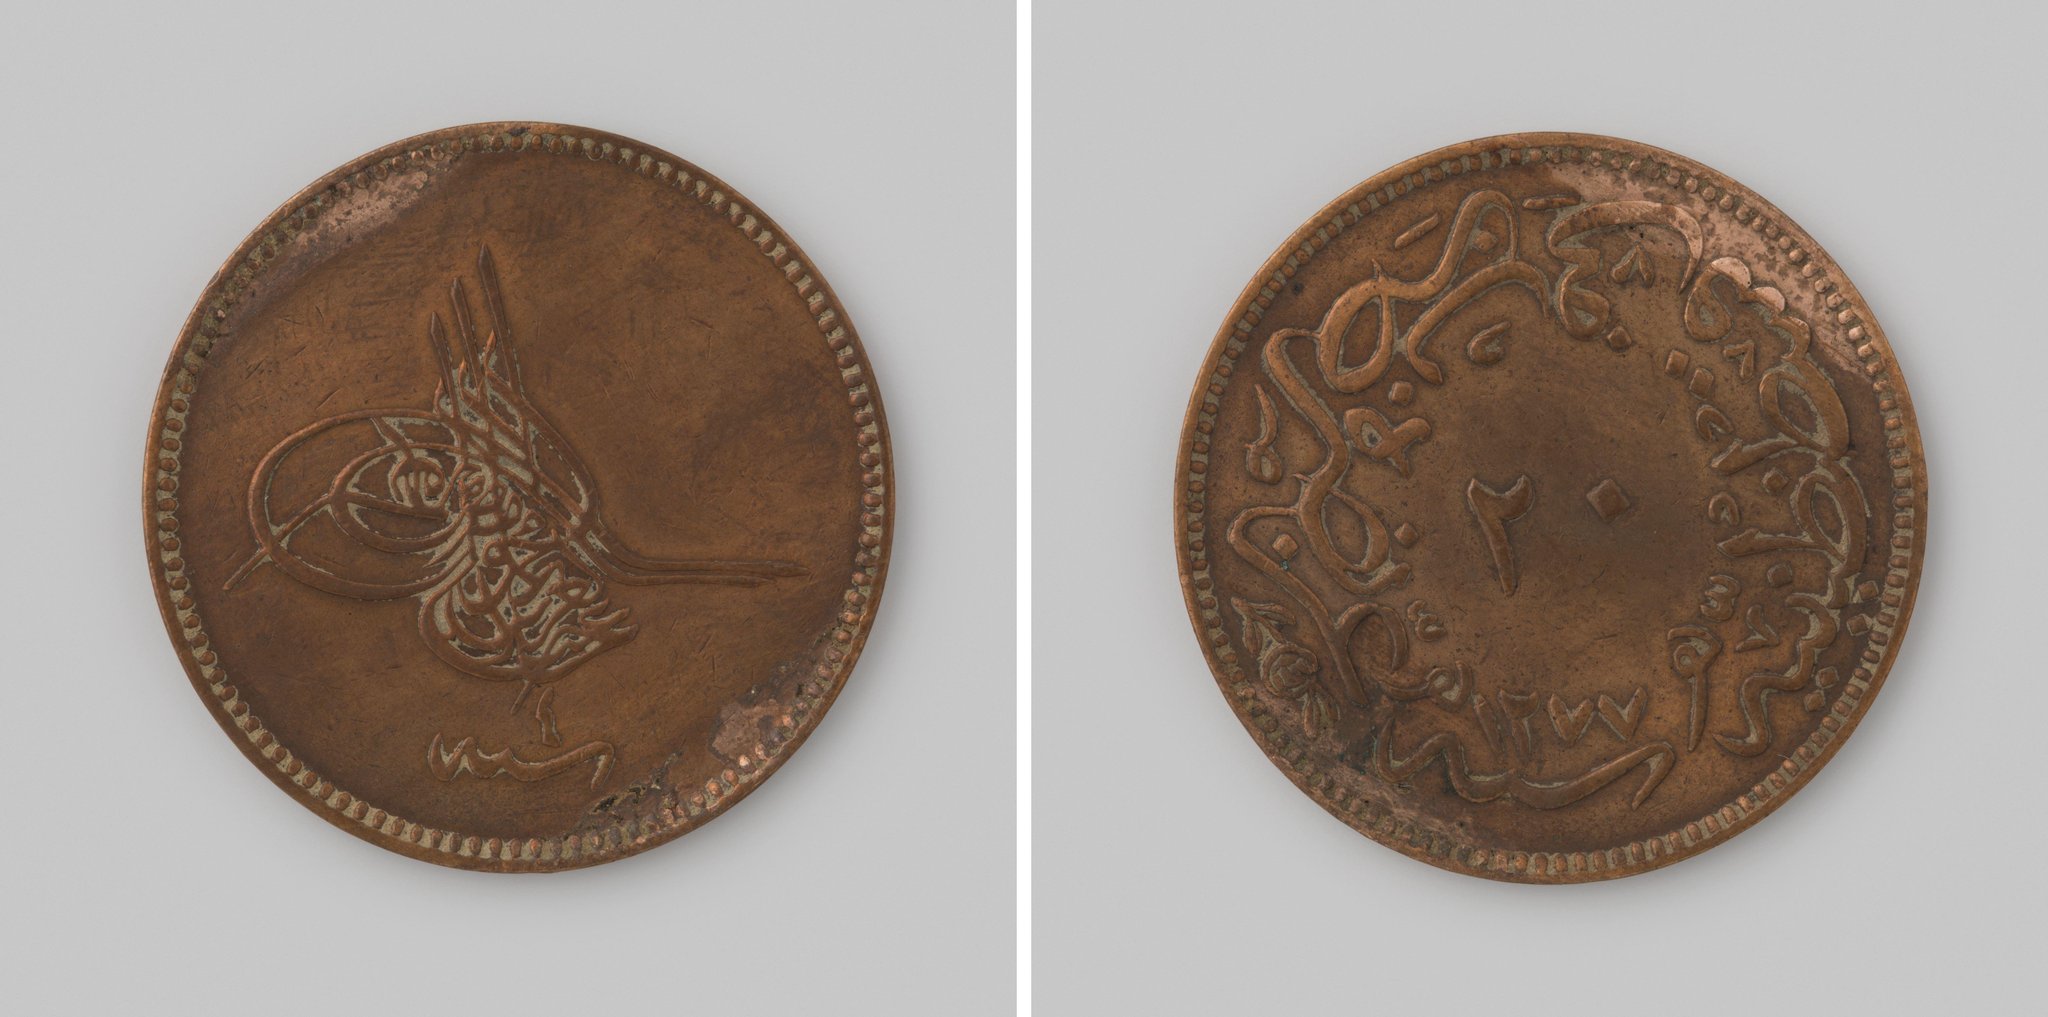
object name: coin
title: 20 para uit Turkije van sultan Abdul Aziz, regeringsjaar 4 [=1864]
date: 1864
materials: copper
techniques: striking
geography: constantinople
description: Koperen munt. Voorzijde: tughra. Onder tughra regeringsjaar-aanduiding:4. Keerzijde: binnen omschrift in Arabische letters waarde-aanduiding: 20. In omschrift muntplaats-aanduiding: Constantinopel en aanduiding jaar van aantreden: 1277 [=1861].